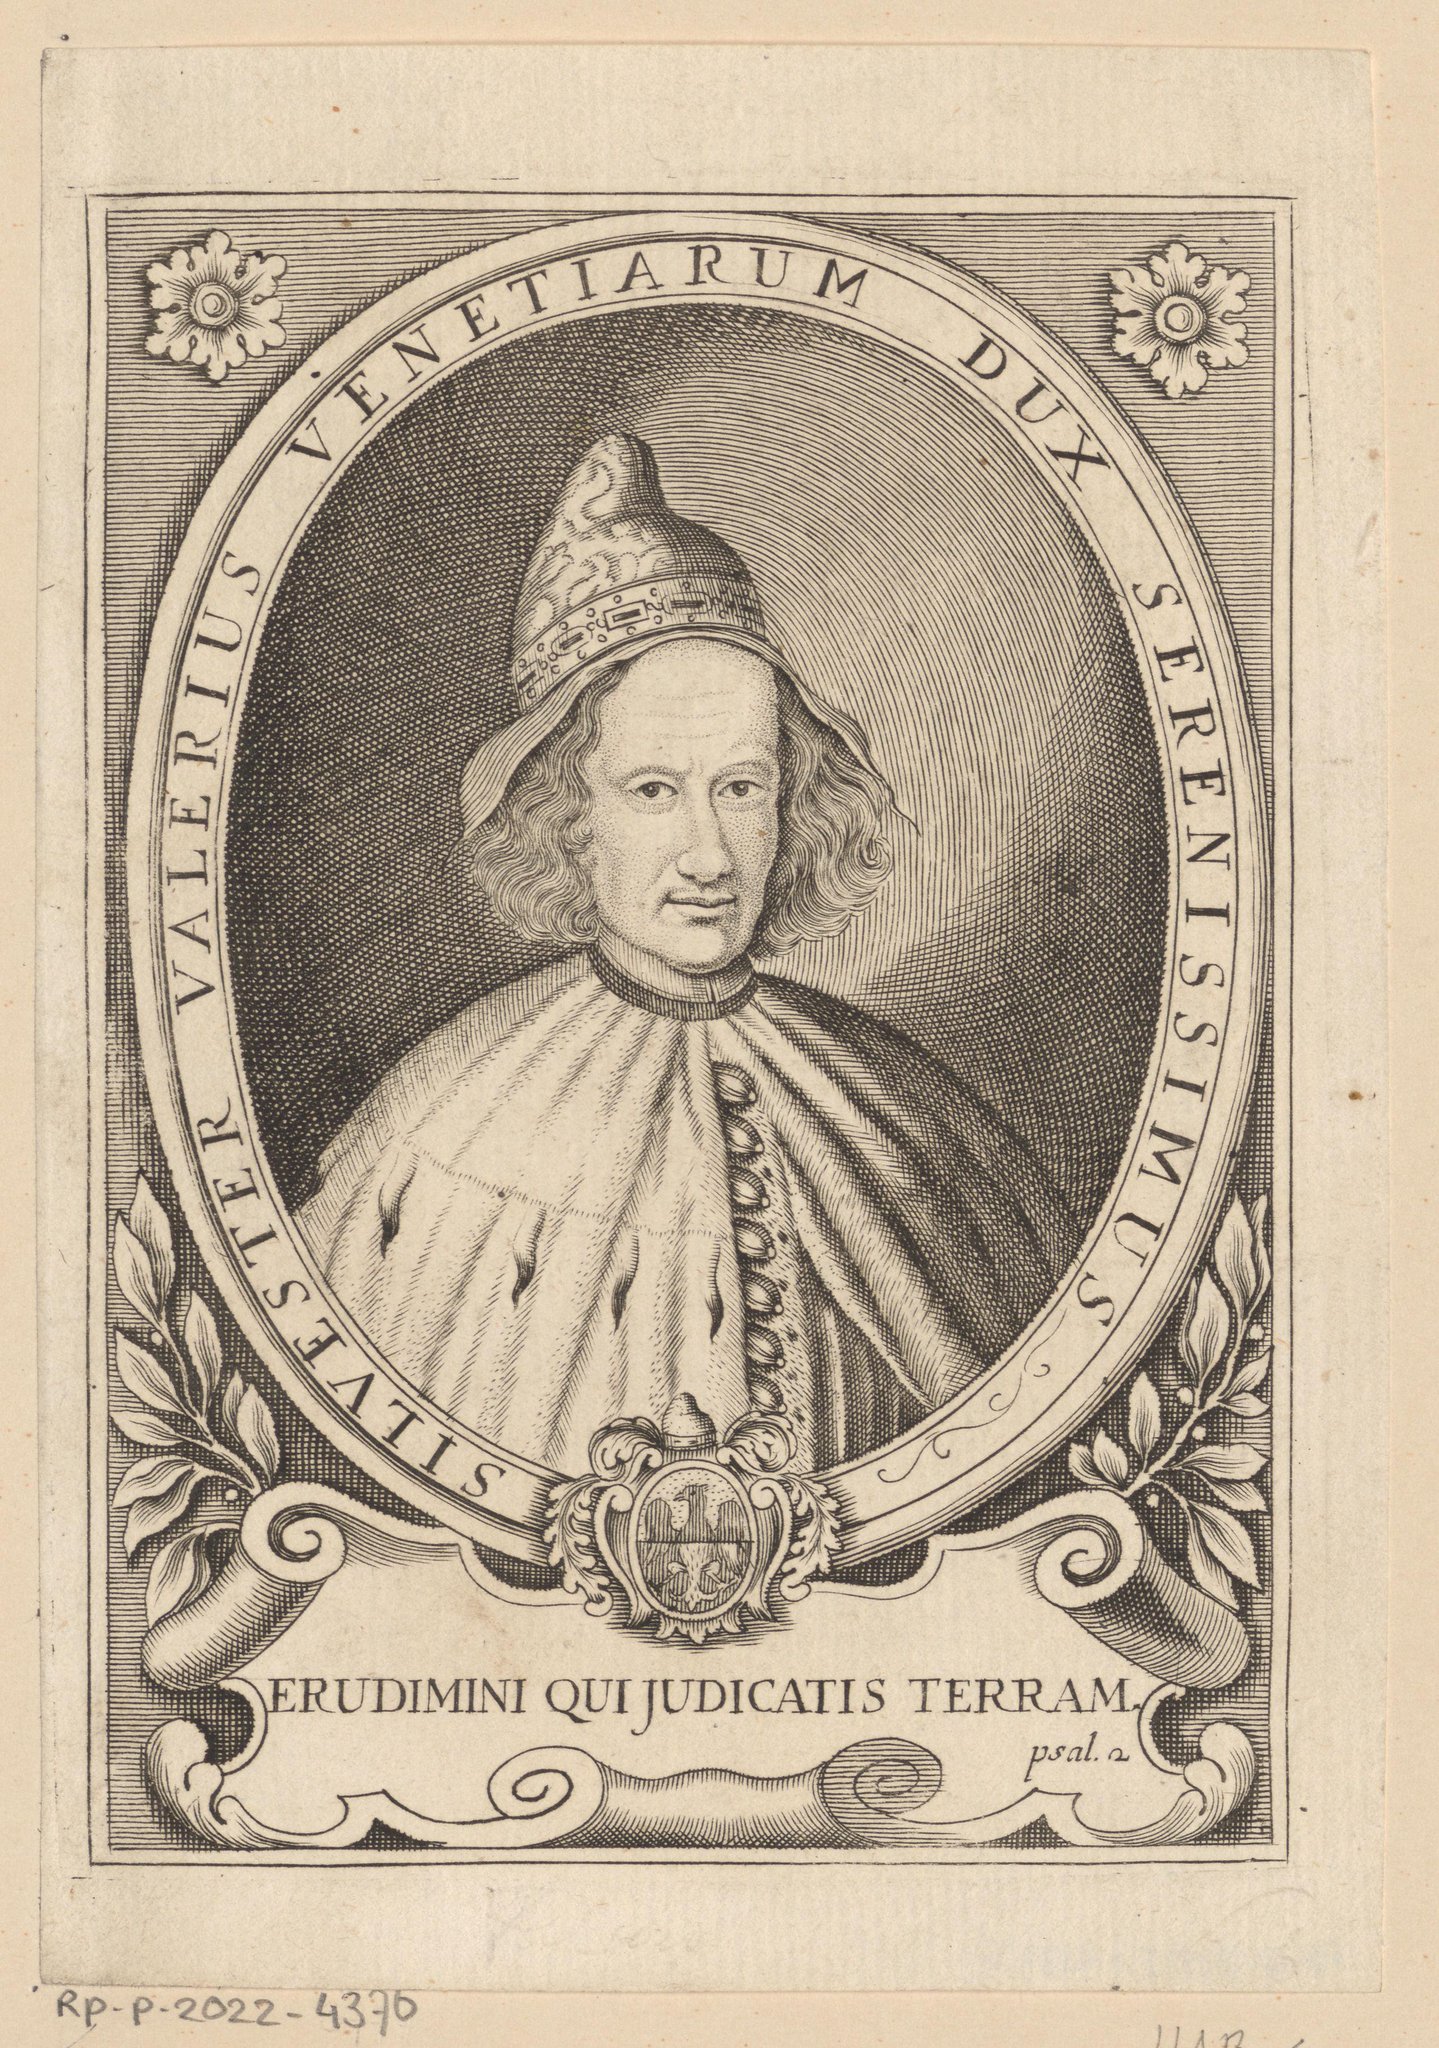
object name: print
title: Portret van Silvestro Valiero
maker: Anonymous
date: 1704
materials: paper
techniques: engraving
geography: italy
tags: historical persons, portrait of a writer, armorial bearing, heraldry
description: Prent waarschijnlijk uit: Rovere, D. Silvestro. Vita del serenissima prencipe Silvestro Valiero (...). Venetië: Antonio Bortoli, 1704.